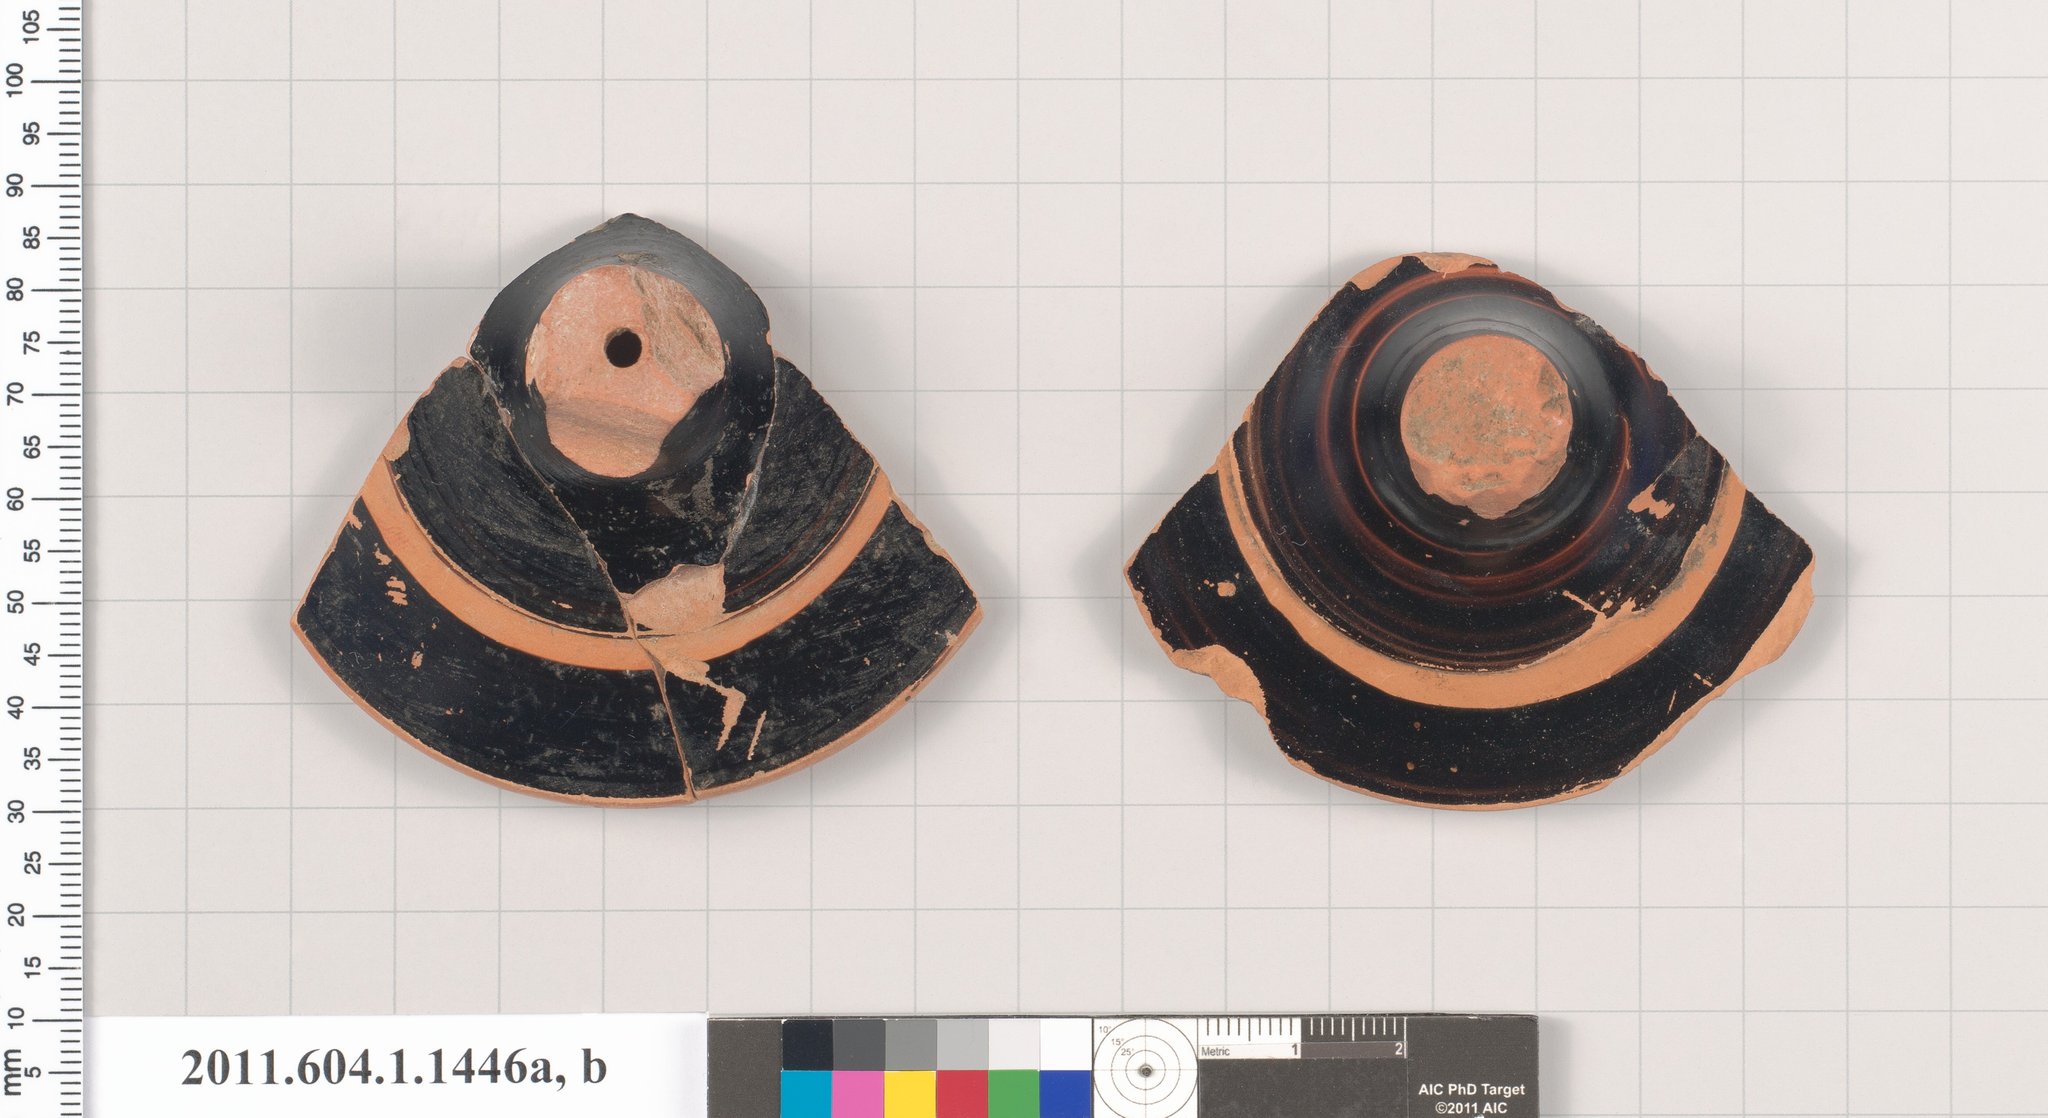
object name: kylix fragment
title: Terracotta fragments of kylikes (drinking cups)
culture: greek, attic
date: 500-401 BCE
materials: terracotta